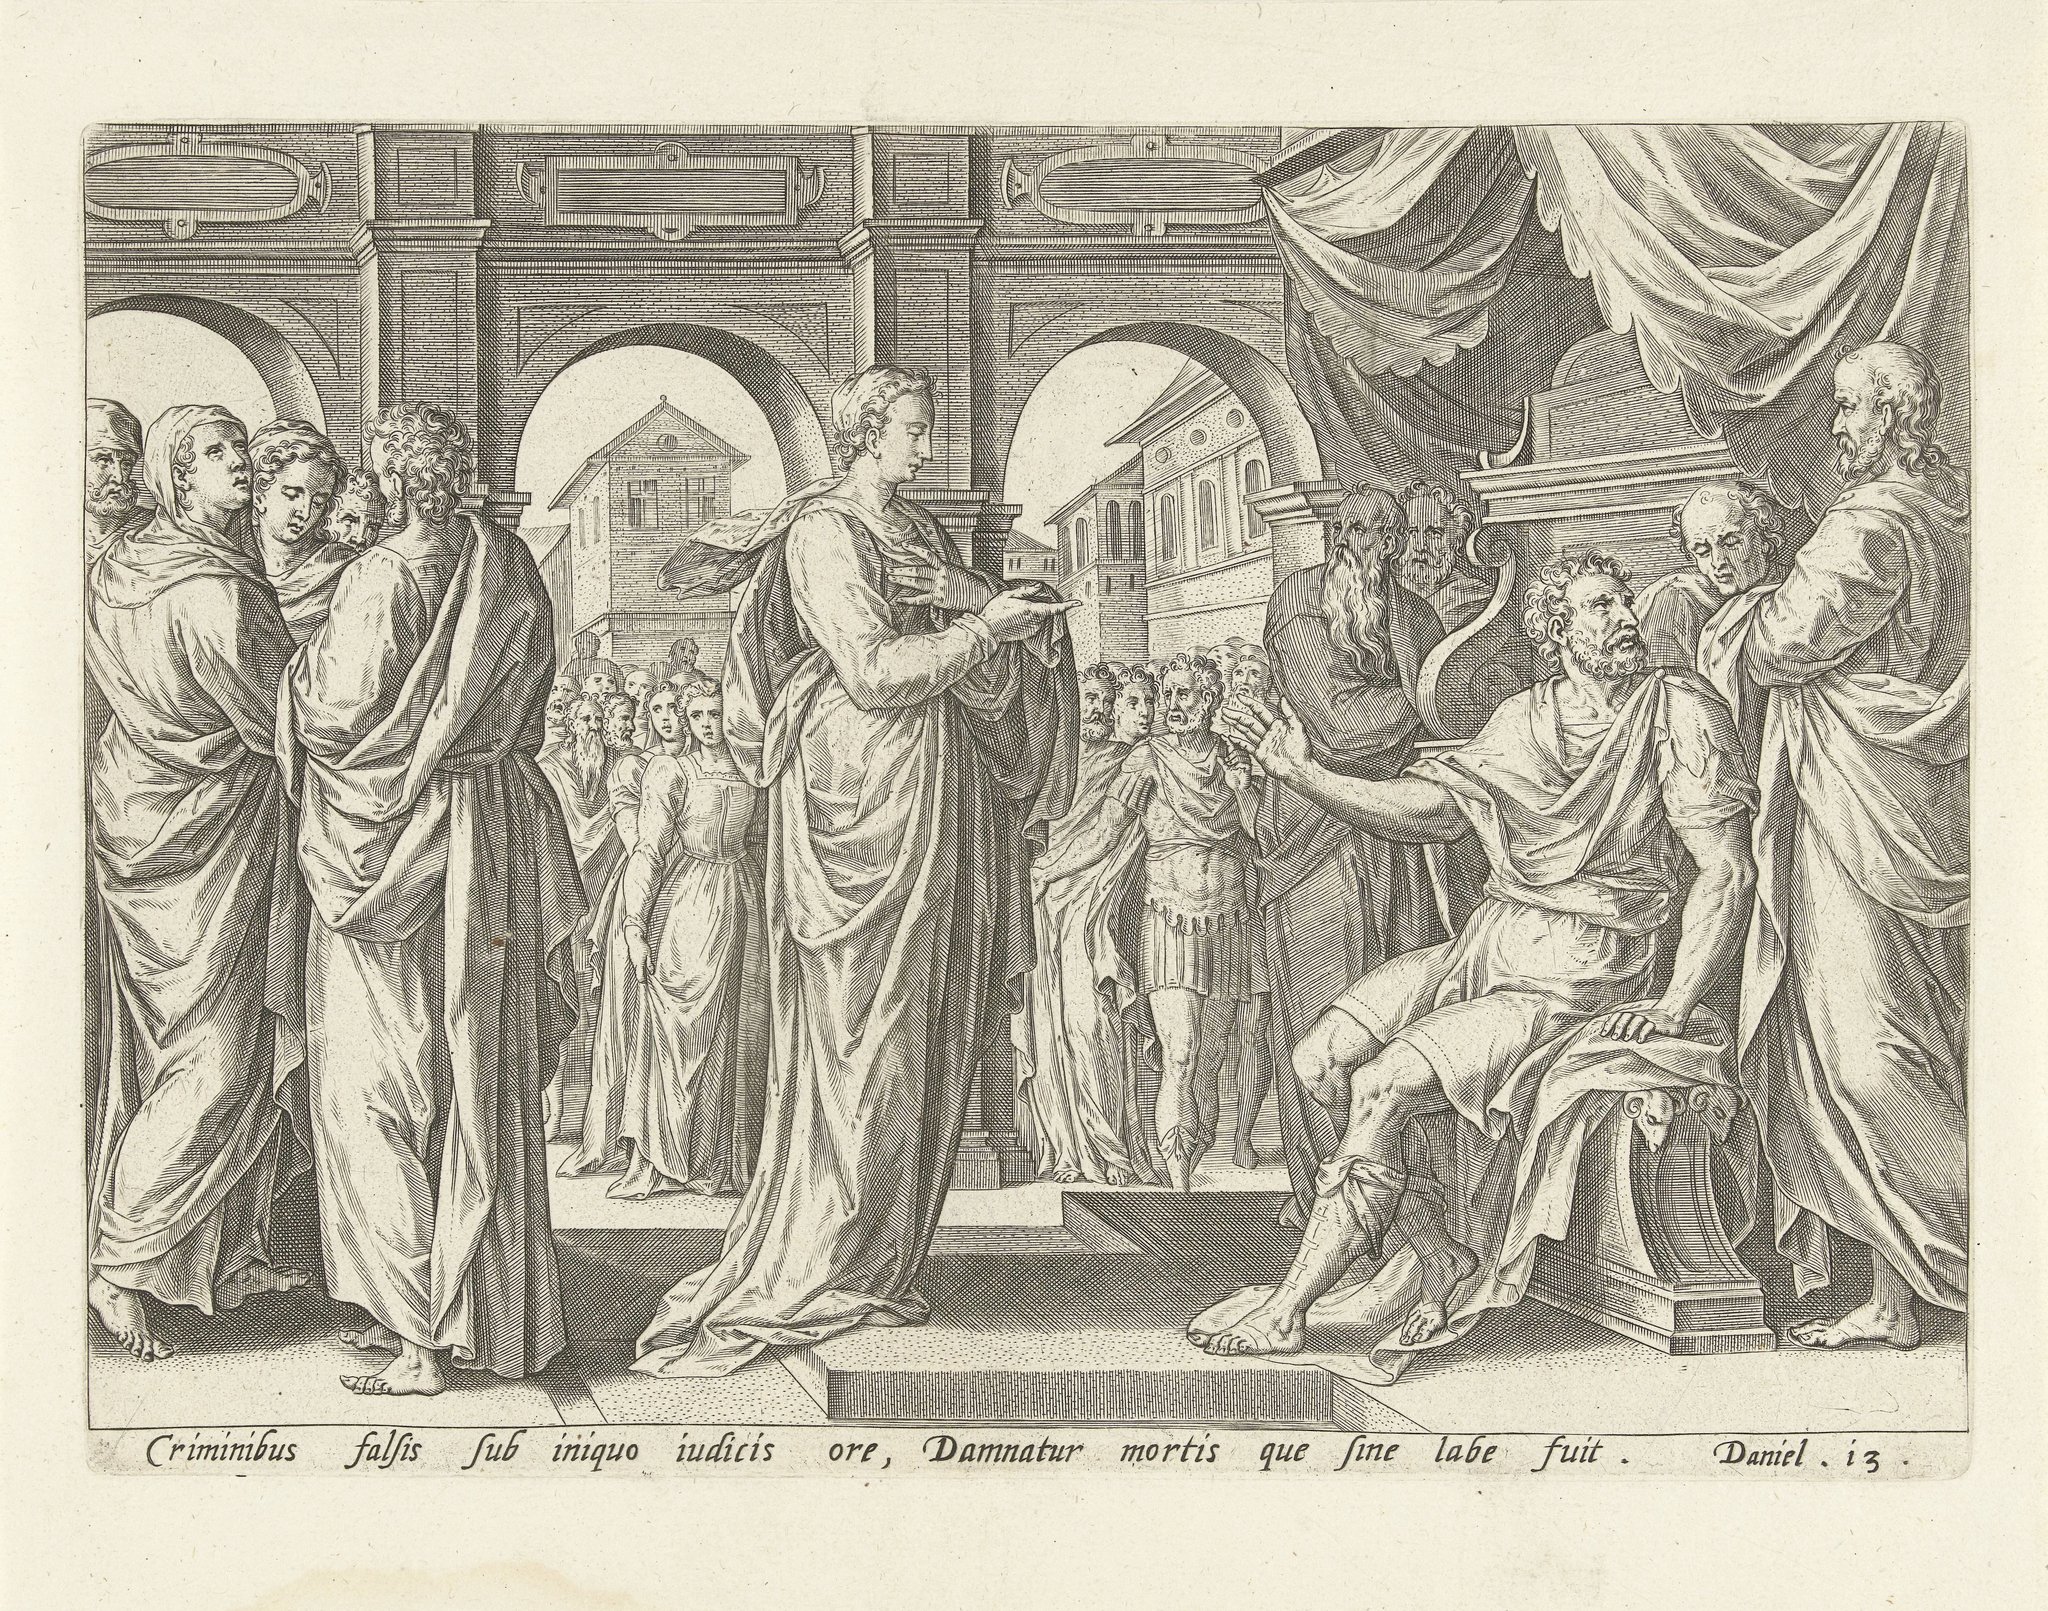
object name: print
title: Susanna voor de rechters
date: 1579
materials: paper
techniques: engraving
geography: antwerp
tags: the elders accusing susanna before the people, laying their hands on her head or unveiling her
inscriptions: collector's mark: Lugt 2228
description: Susanne wordt voor de ouderlingen geleid, die haar beschuldigen van ontrouw. Als rechters veroordelen ze haar ook. De prent heeft een Latijns onderschrift en is deel van een serie met het verhaal van Susanna (Daniël 13:1-64).